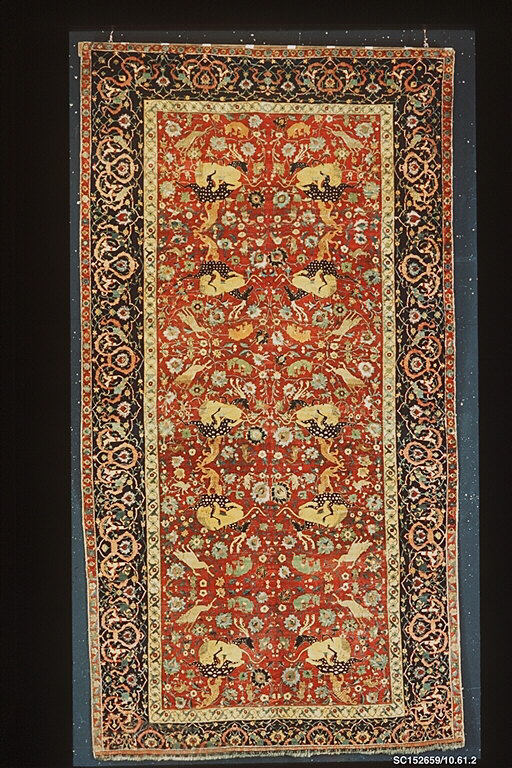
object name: carpet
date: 1501-1600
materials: silk, wool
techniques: asymmetrically knotted pile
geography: iran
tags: animals,boars,lions,tigers